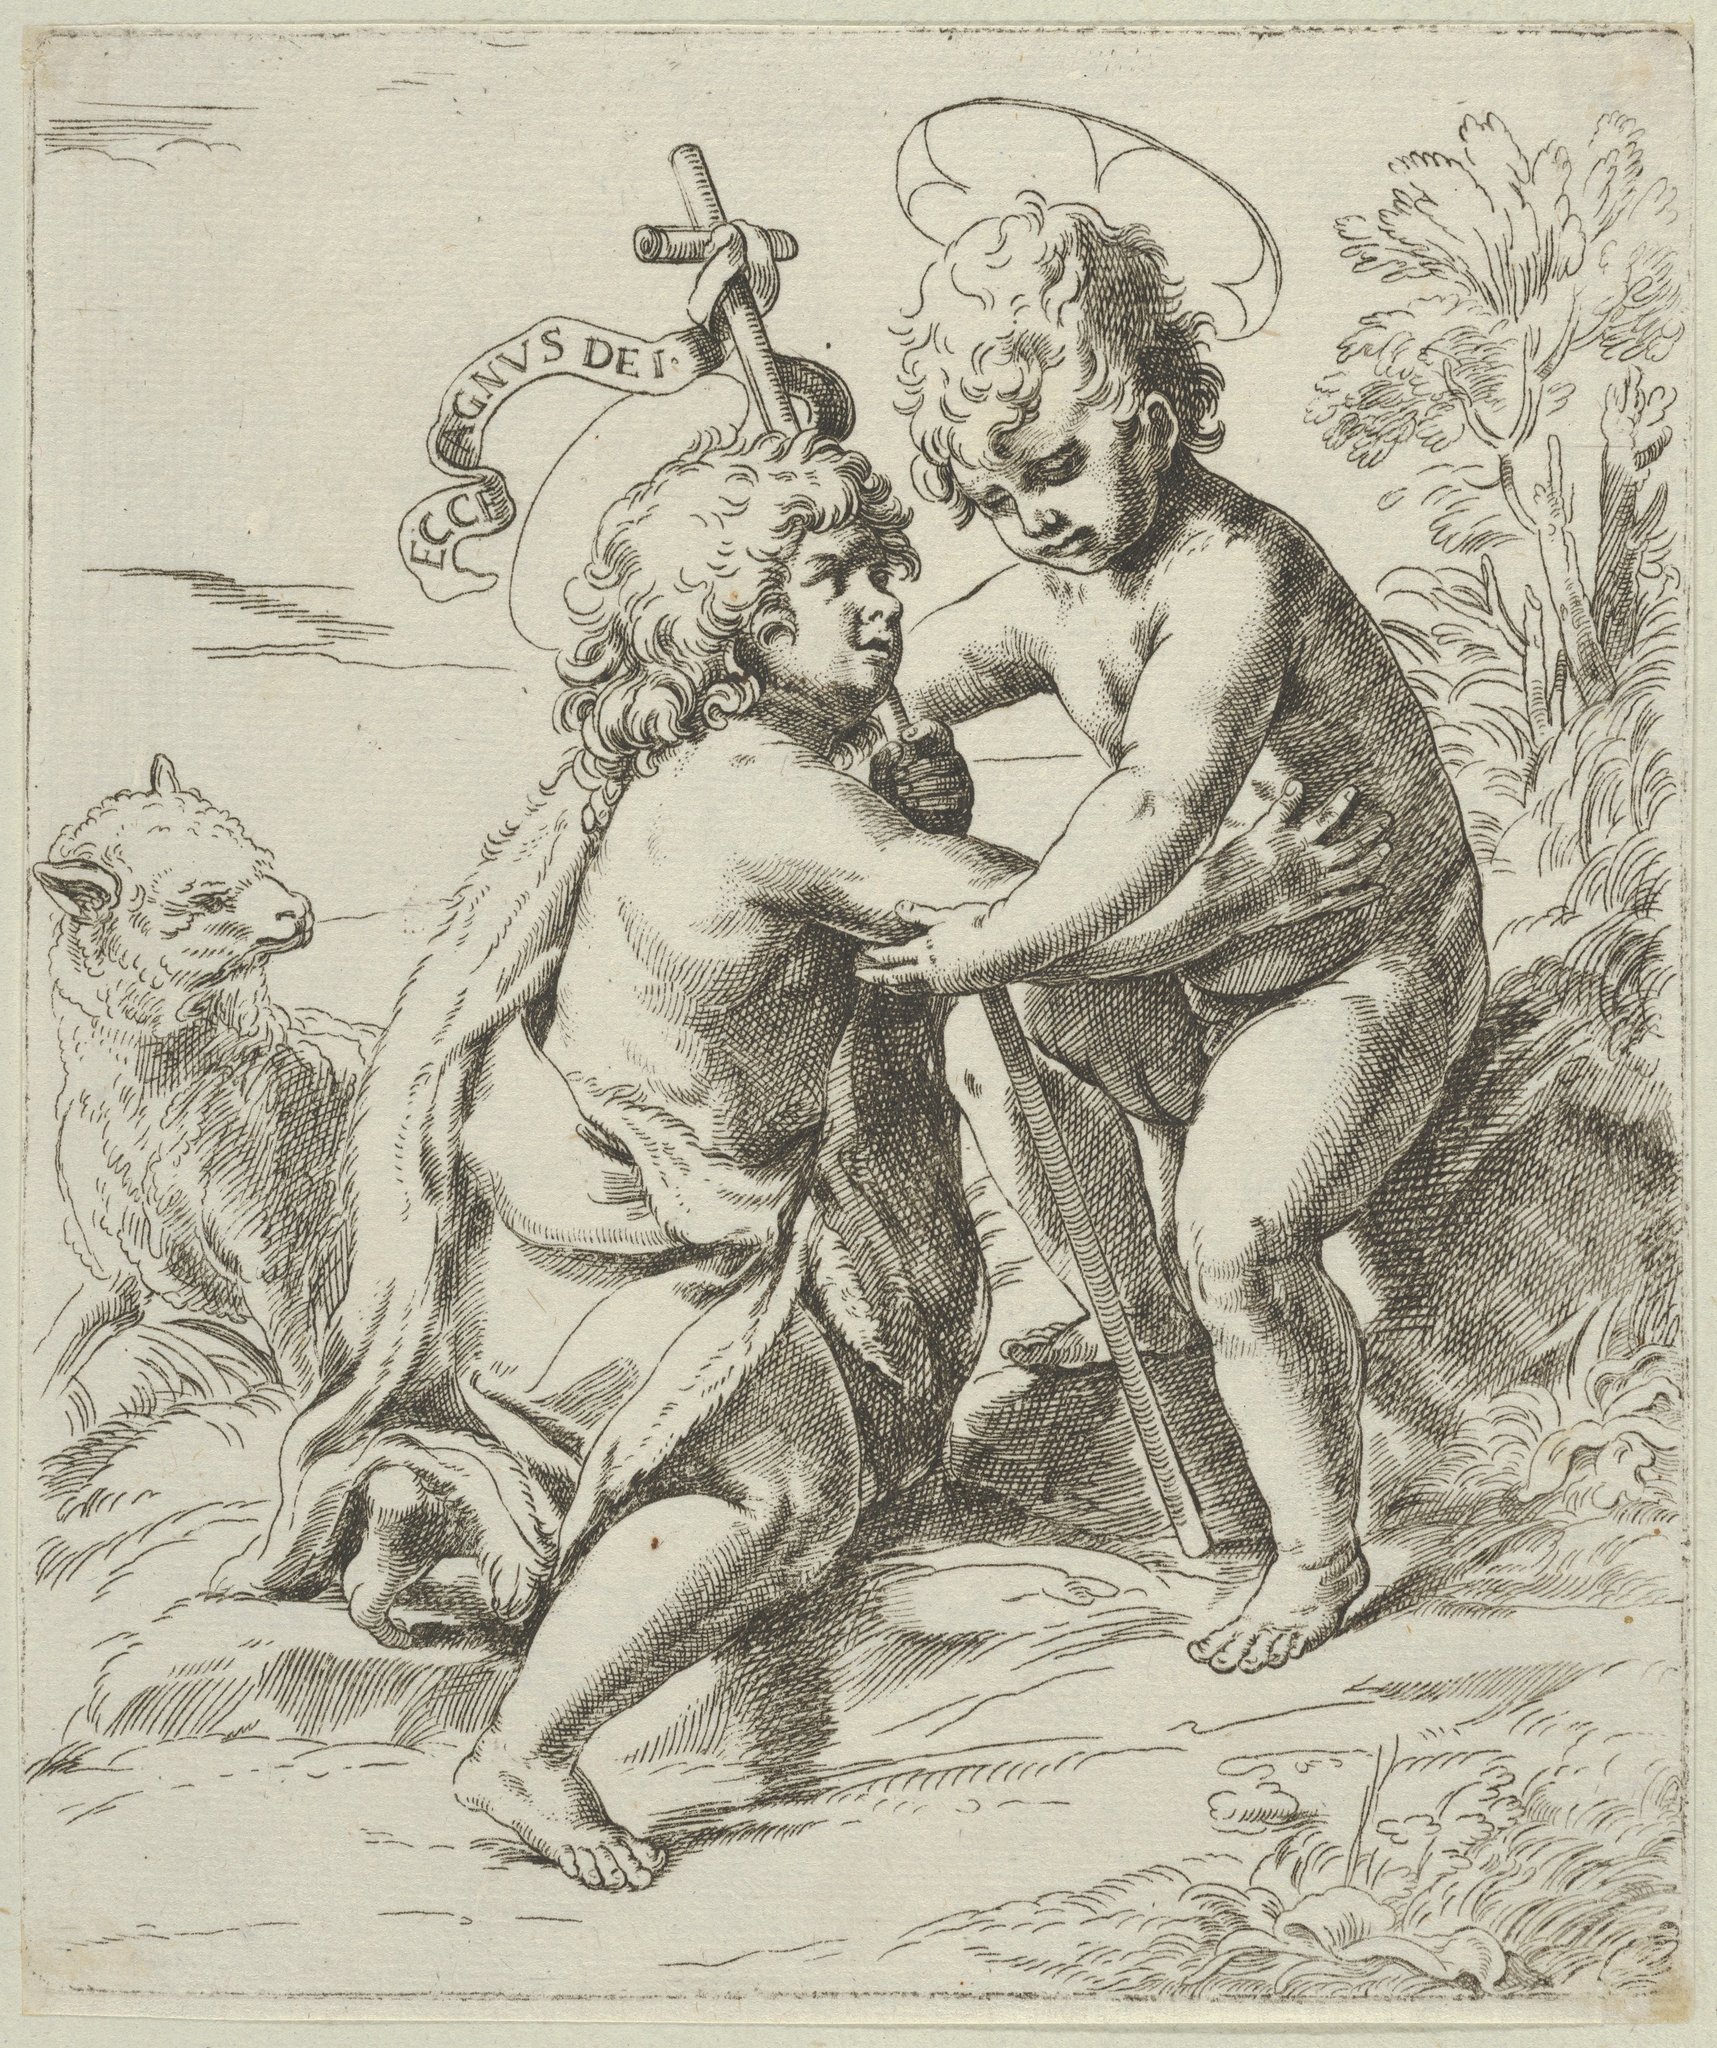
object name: print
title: The young Saint John the Baptist kneeling before the young Christ who embraces him, a lamb at left, after Reni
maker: anonymous, 17th century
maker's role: artist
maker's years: 1600-1700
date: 1600-1640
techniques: etching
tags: lambs,christ,saint john the baptist